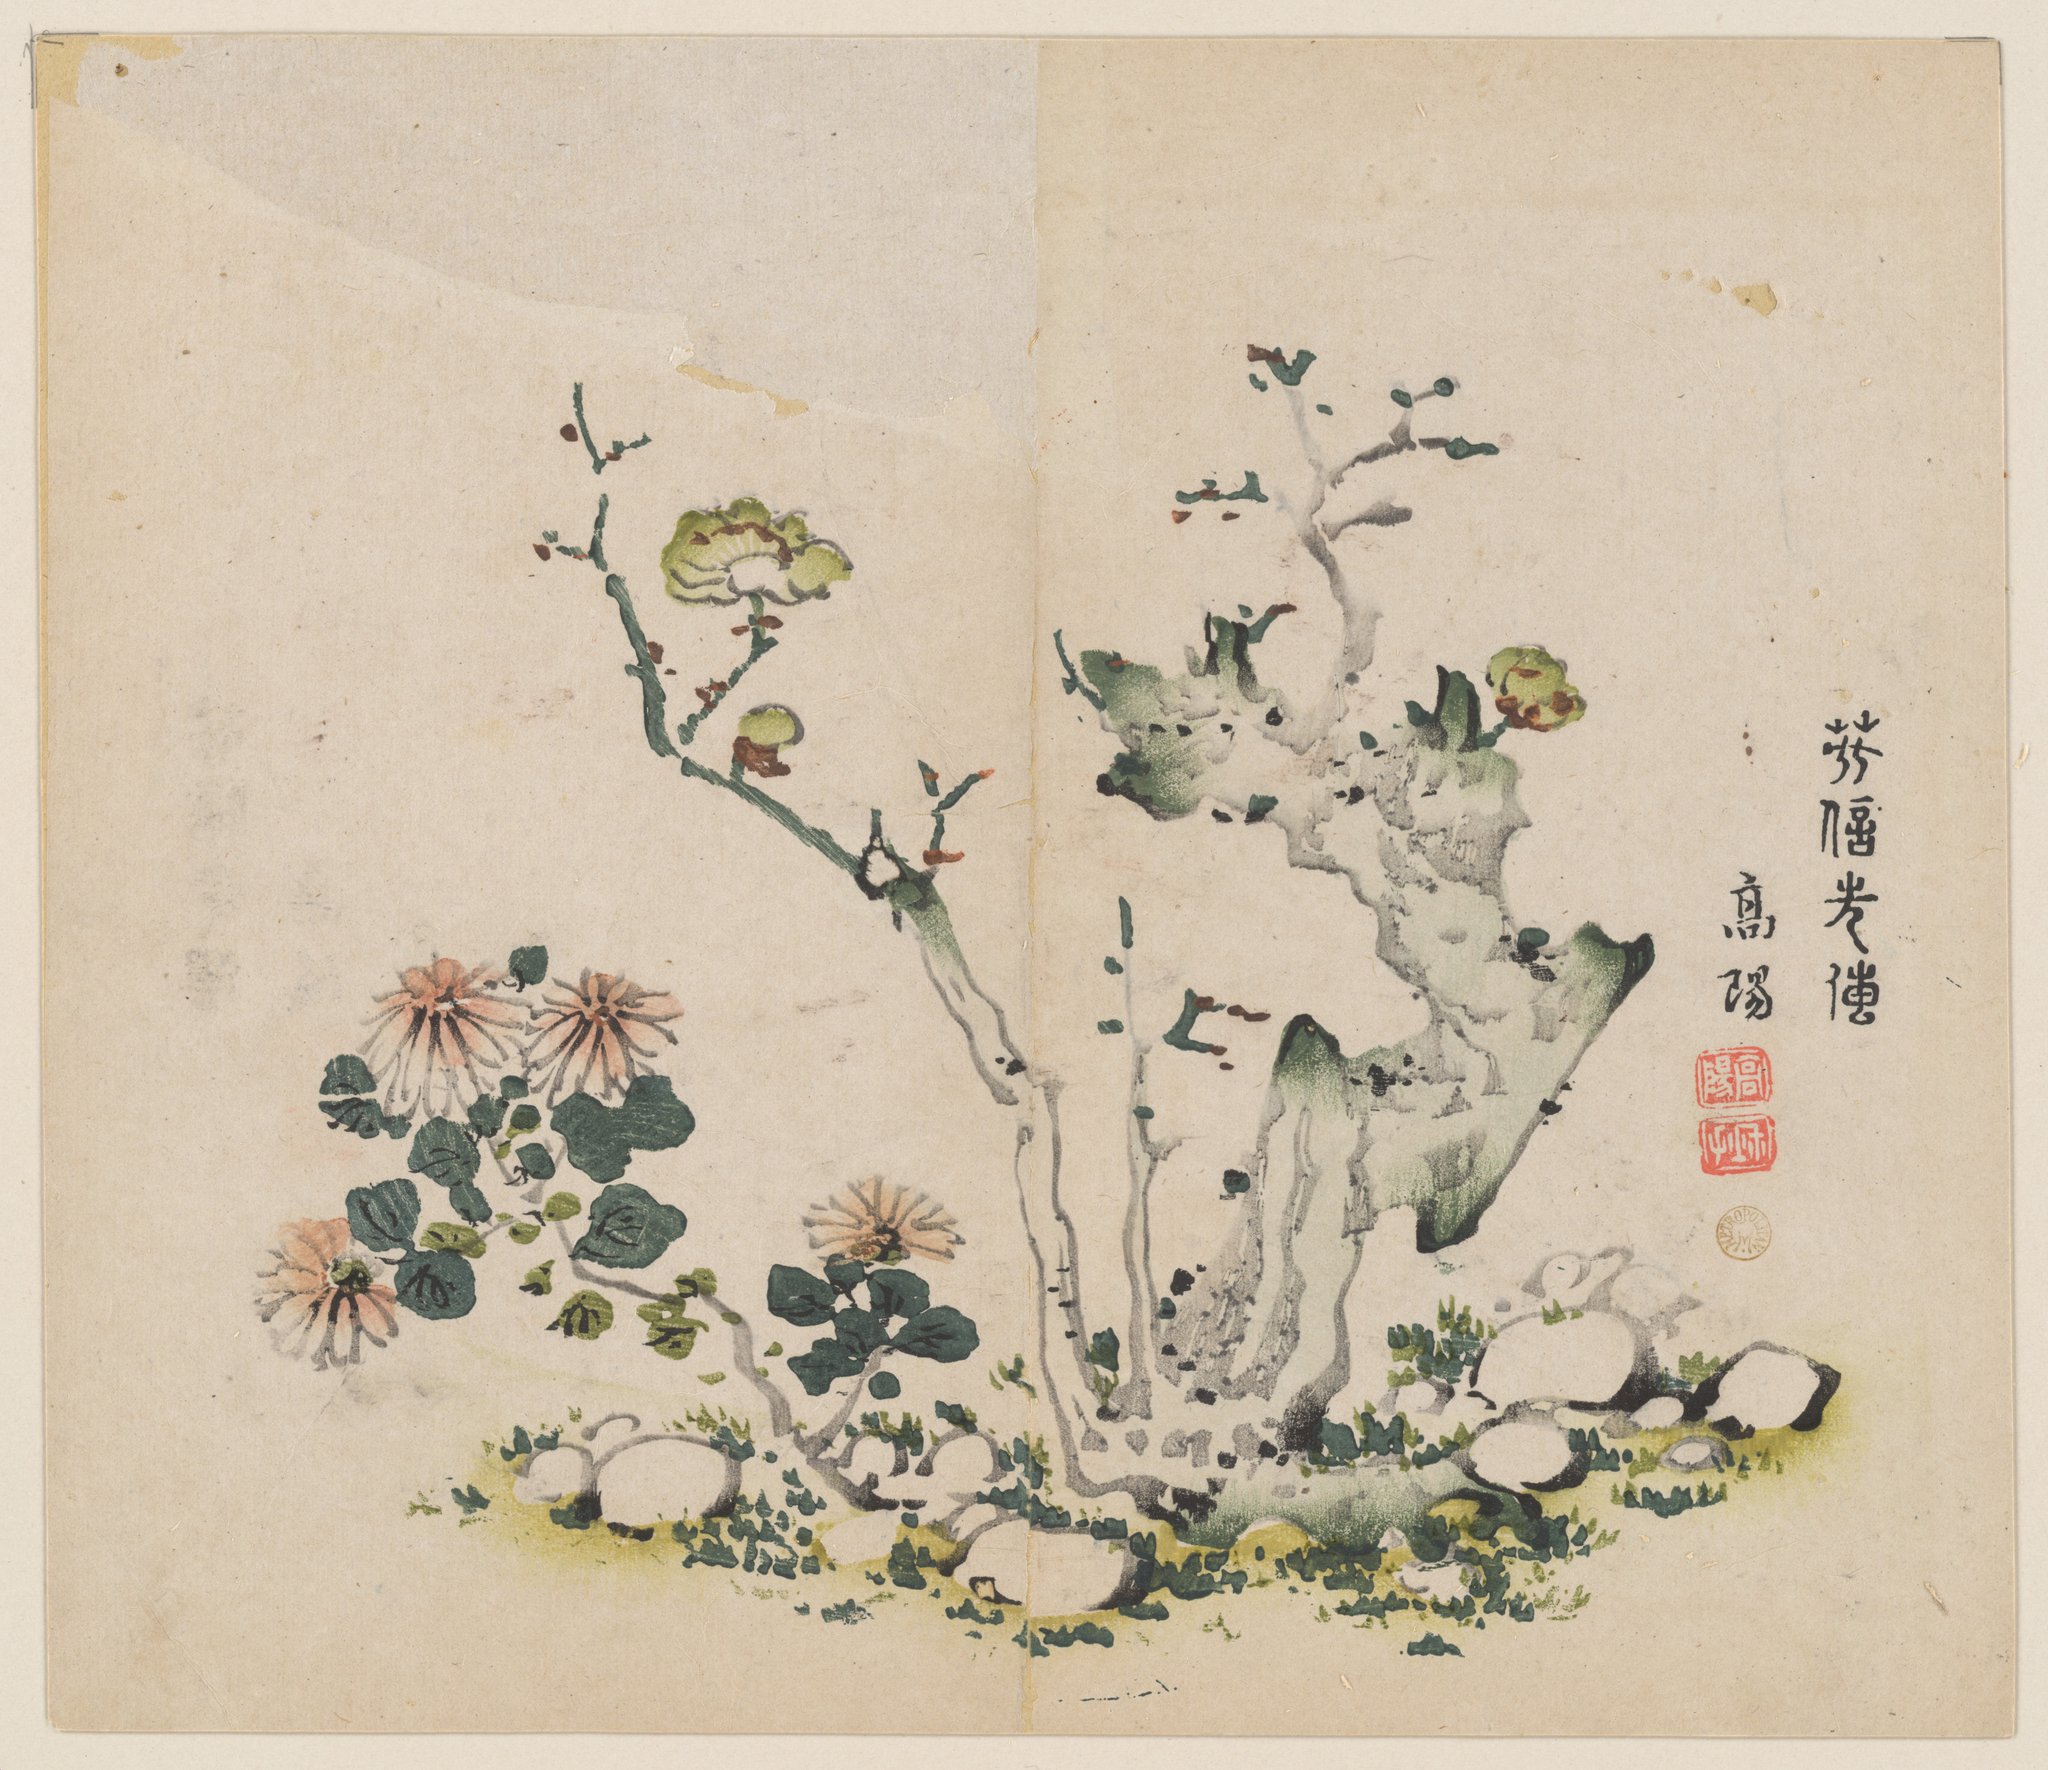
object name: print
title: Page from the Ten Bamboo Studio Manual of Painting and Calligraphy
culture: chinese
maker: hu zhengyan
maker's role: artist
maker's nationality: chinese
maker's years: 1584-1634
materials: ink, paper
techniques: printing